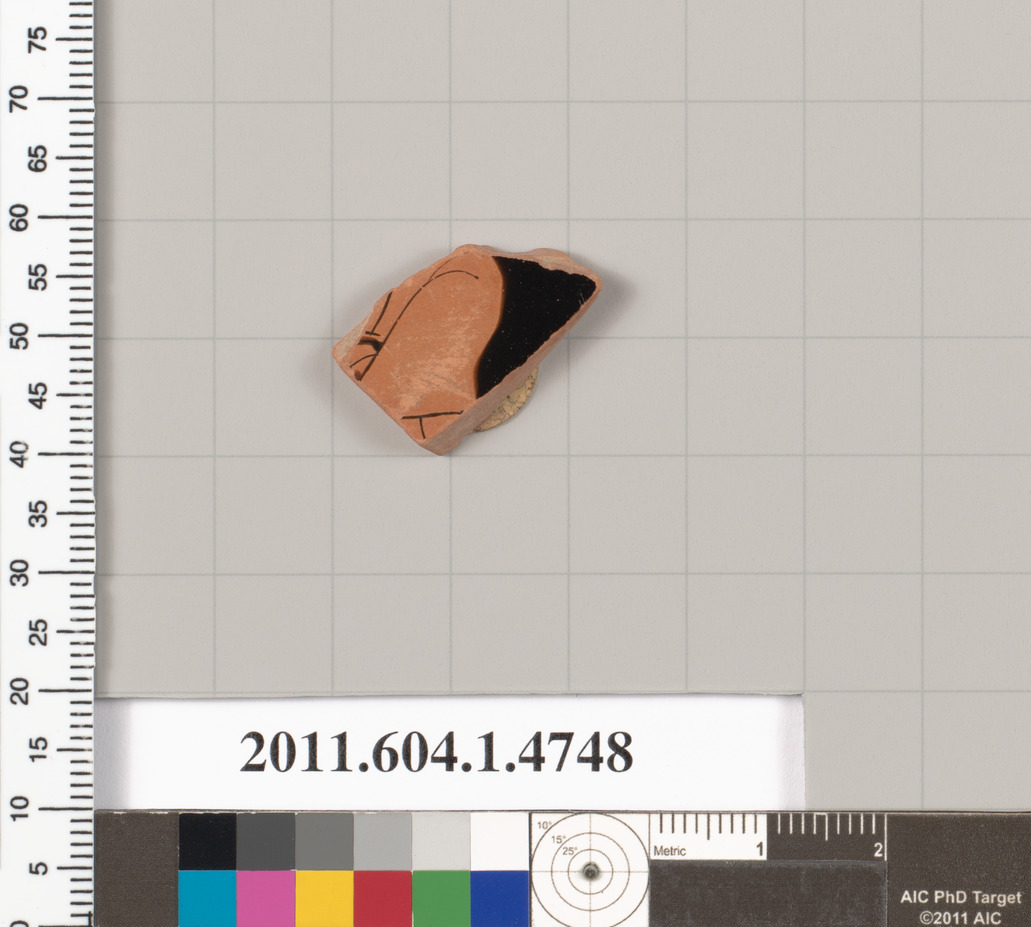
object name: kylix fragment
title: Terracotta fragment of a kylix (drinking cup)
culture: greek, attic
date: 475-451 BCE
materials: terracotta